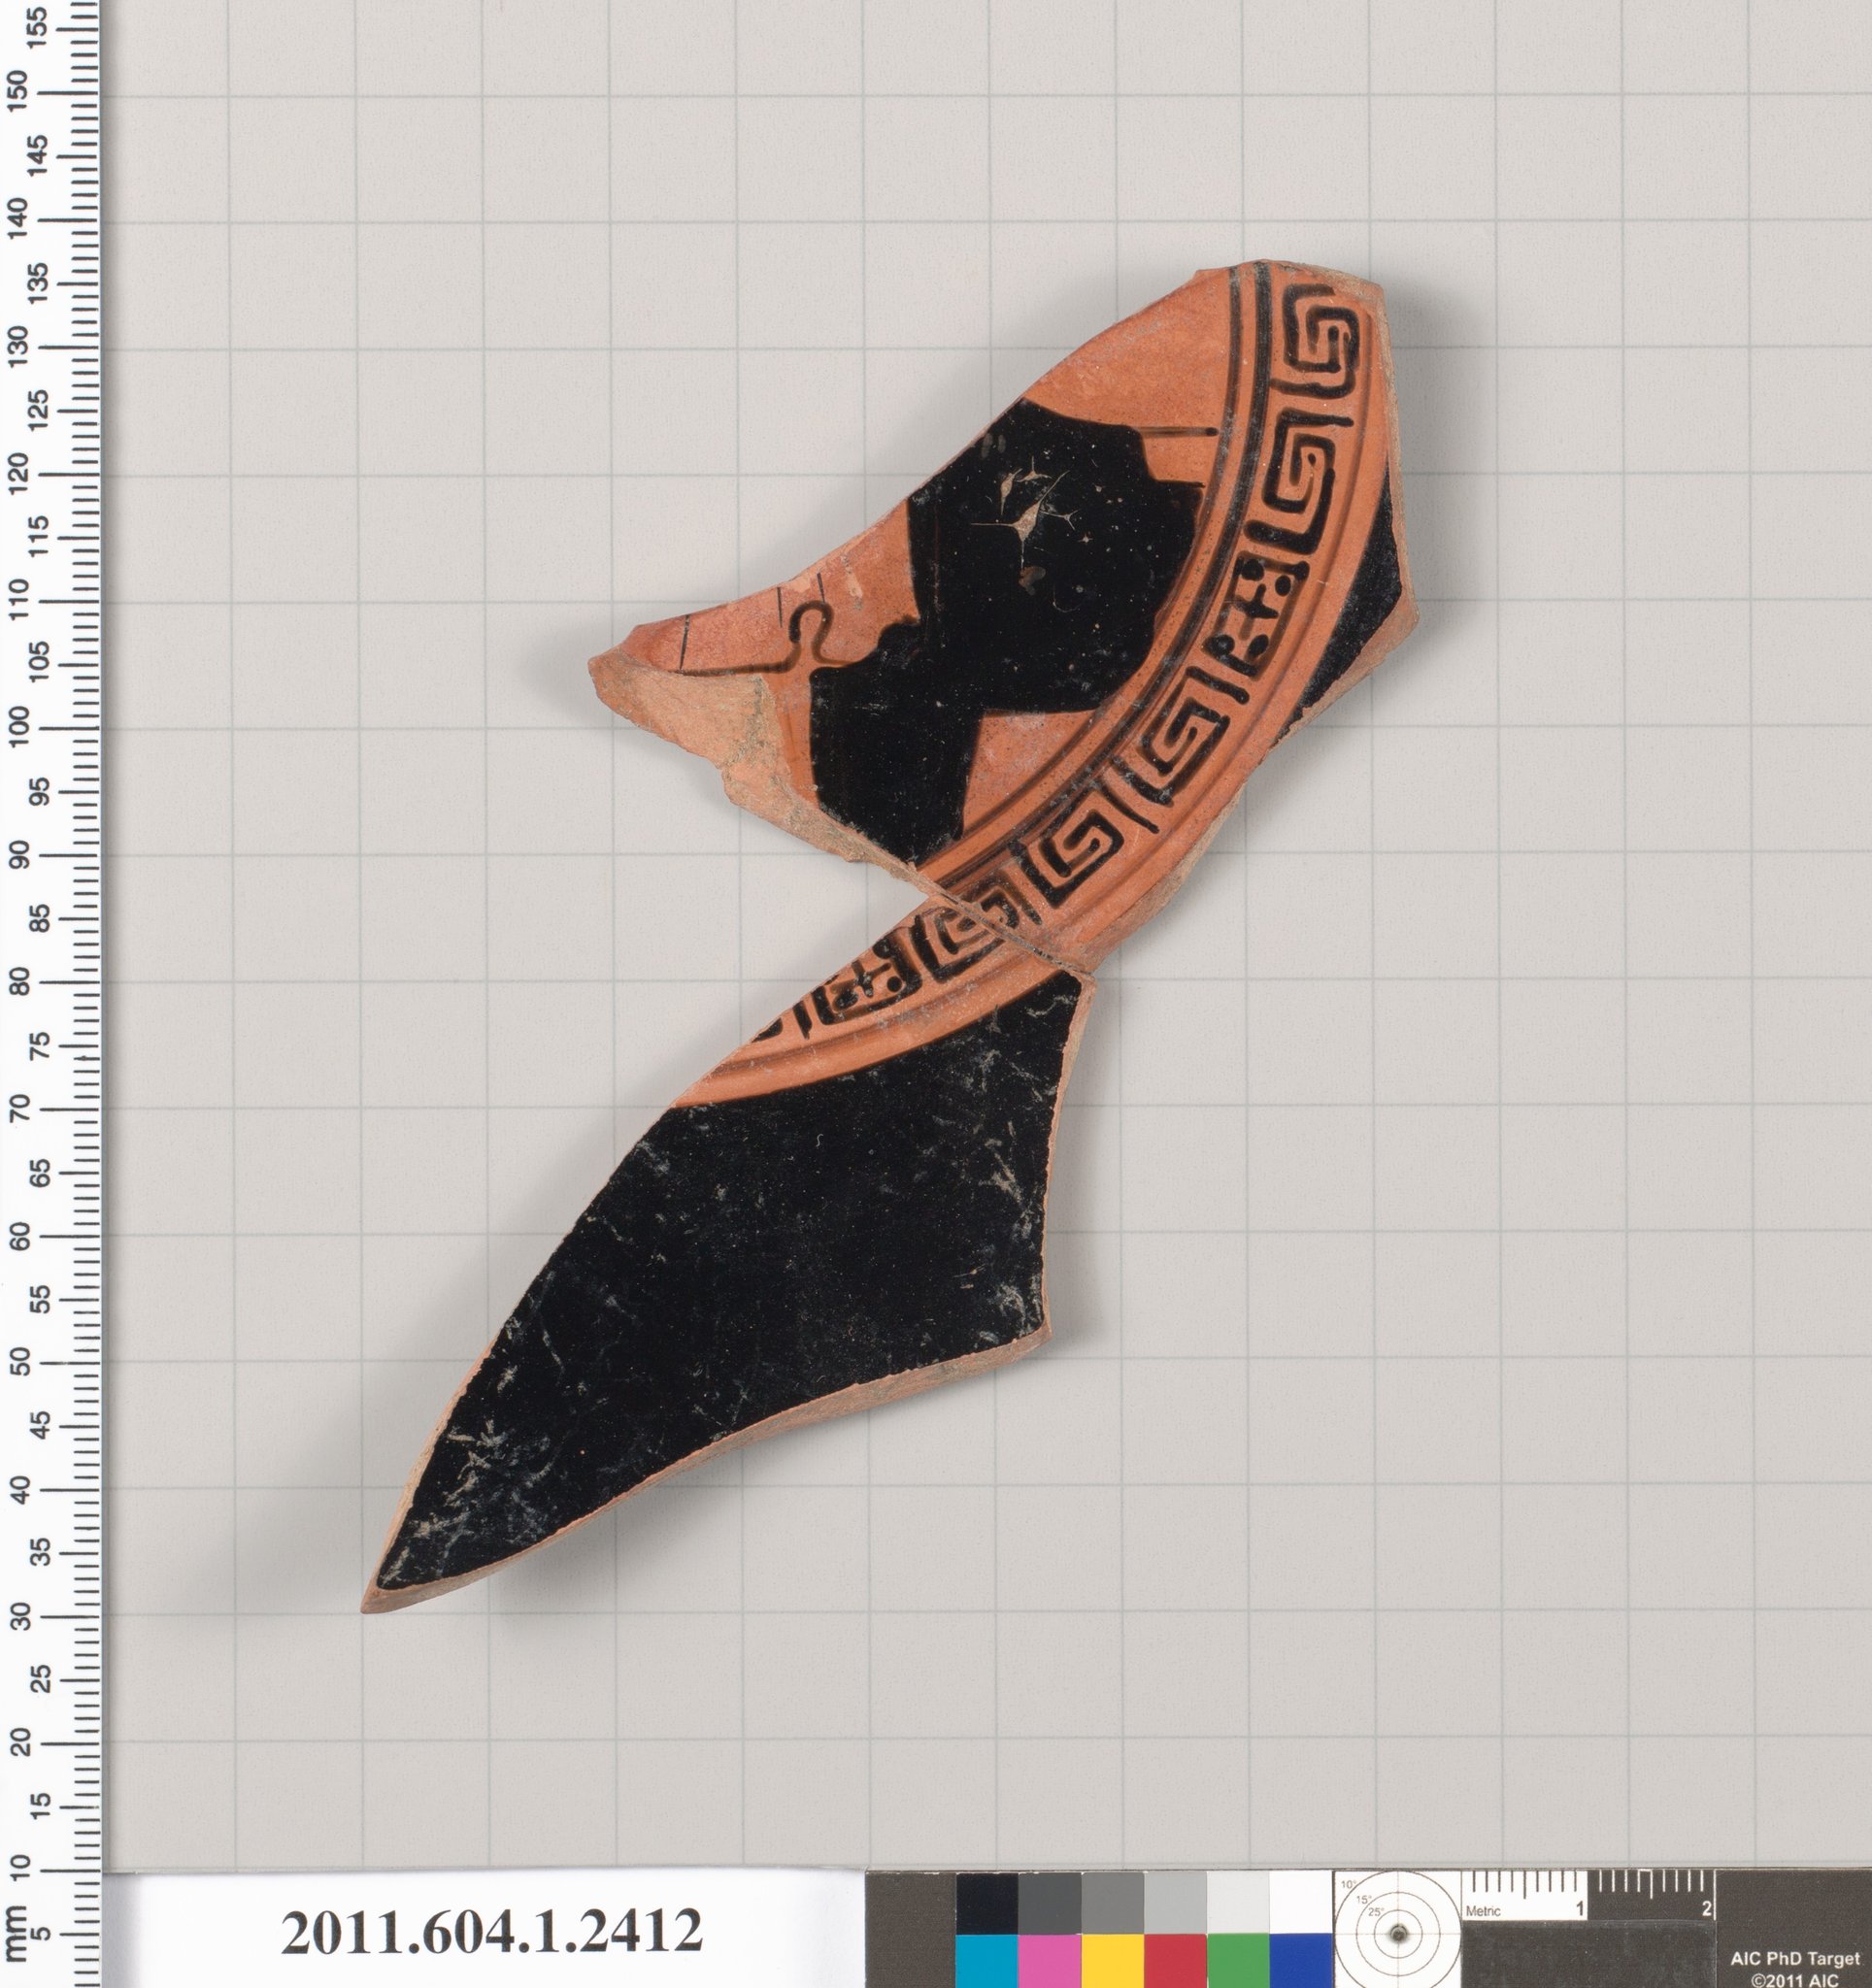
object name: kylix fragment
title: Terracotta fragment of a kylix (drinking cup)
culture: greek, attic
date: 470-460 BCE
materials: terracotta